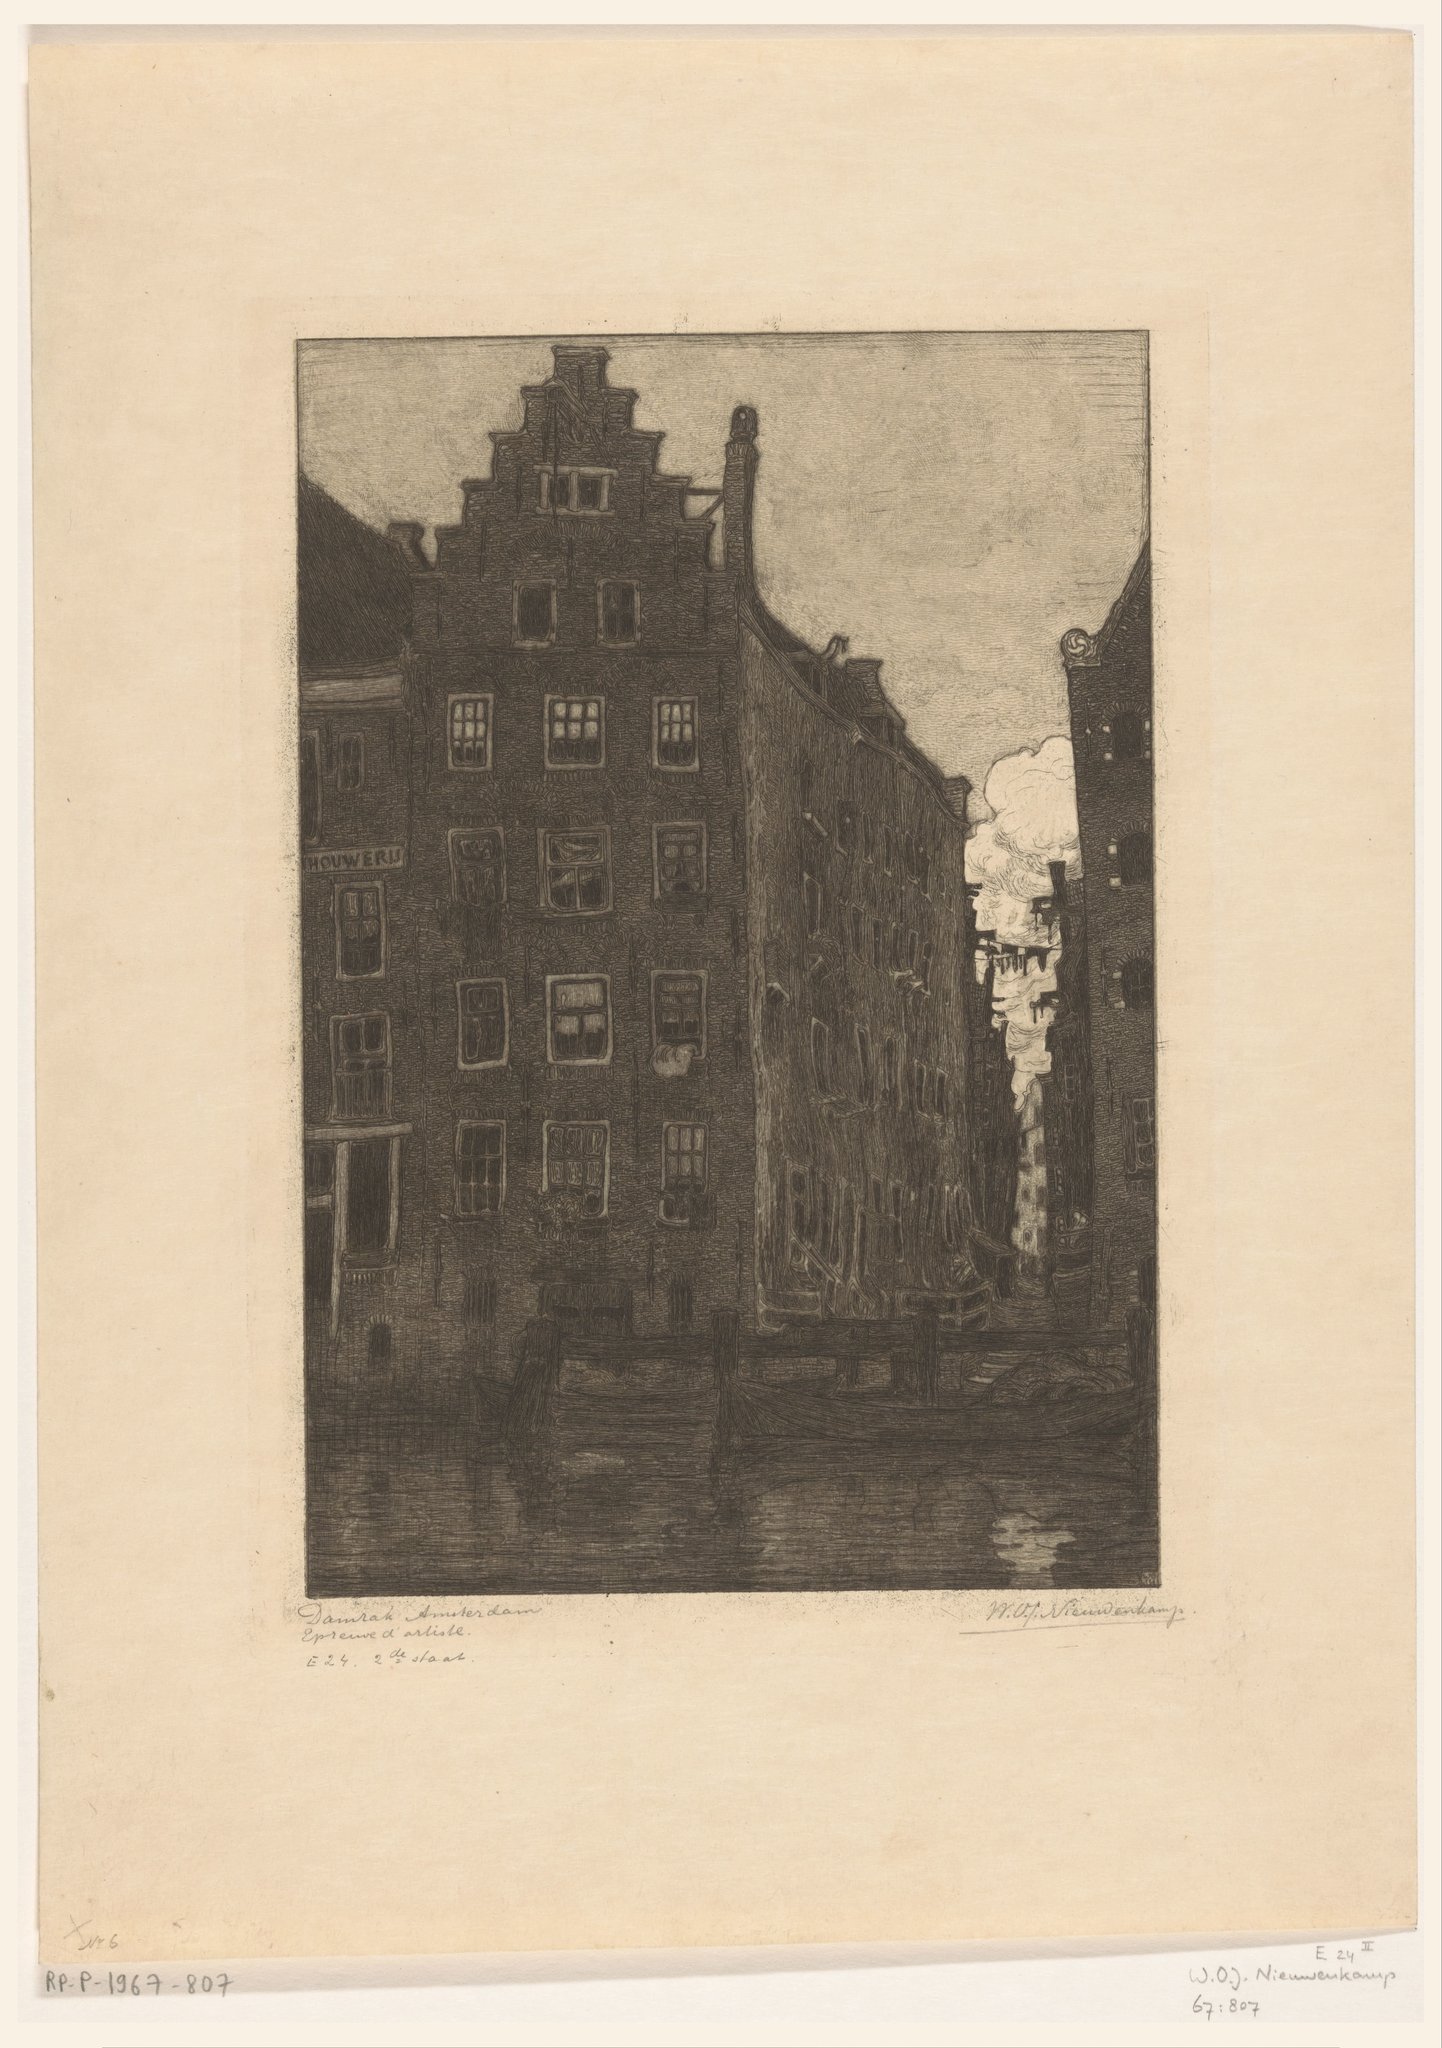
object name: print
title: Aan het Damrak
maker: wijnand otto jan nieuwenkamp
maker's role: draughtsman, print maker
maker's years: 1874-1950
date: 1897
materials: paper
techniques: etching, intaglio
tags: canals, waters (in city), lane, alley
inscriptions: collector's mark: Lugt 2228, collector's mark: Lugt 2760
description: De achtergevels van huizen aan het ongedempte gedeelte van het Damrak in Amsterdam. Rechts de Guldehandsteeg. Op de voorgrond schuiten bij een houten steiger.